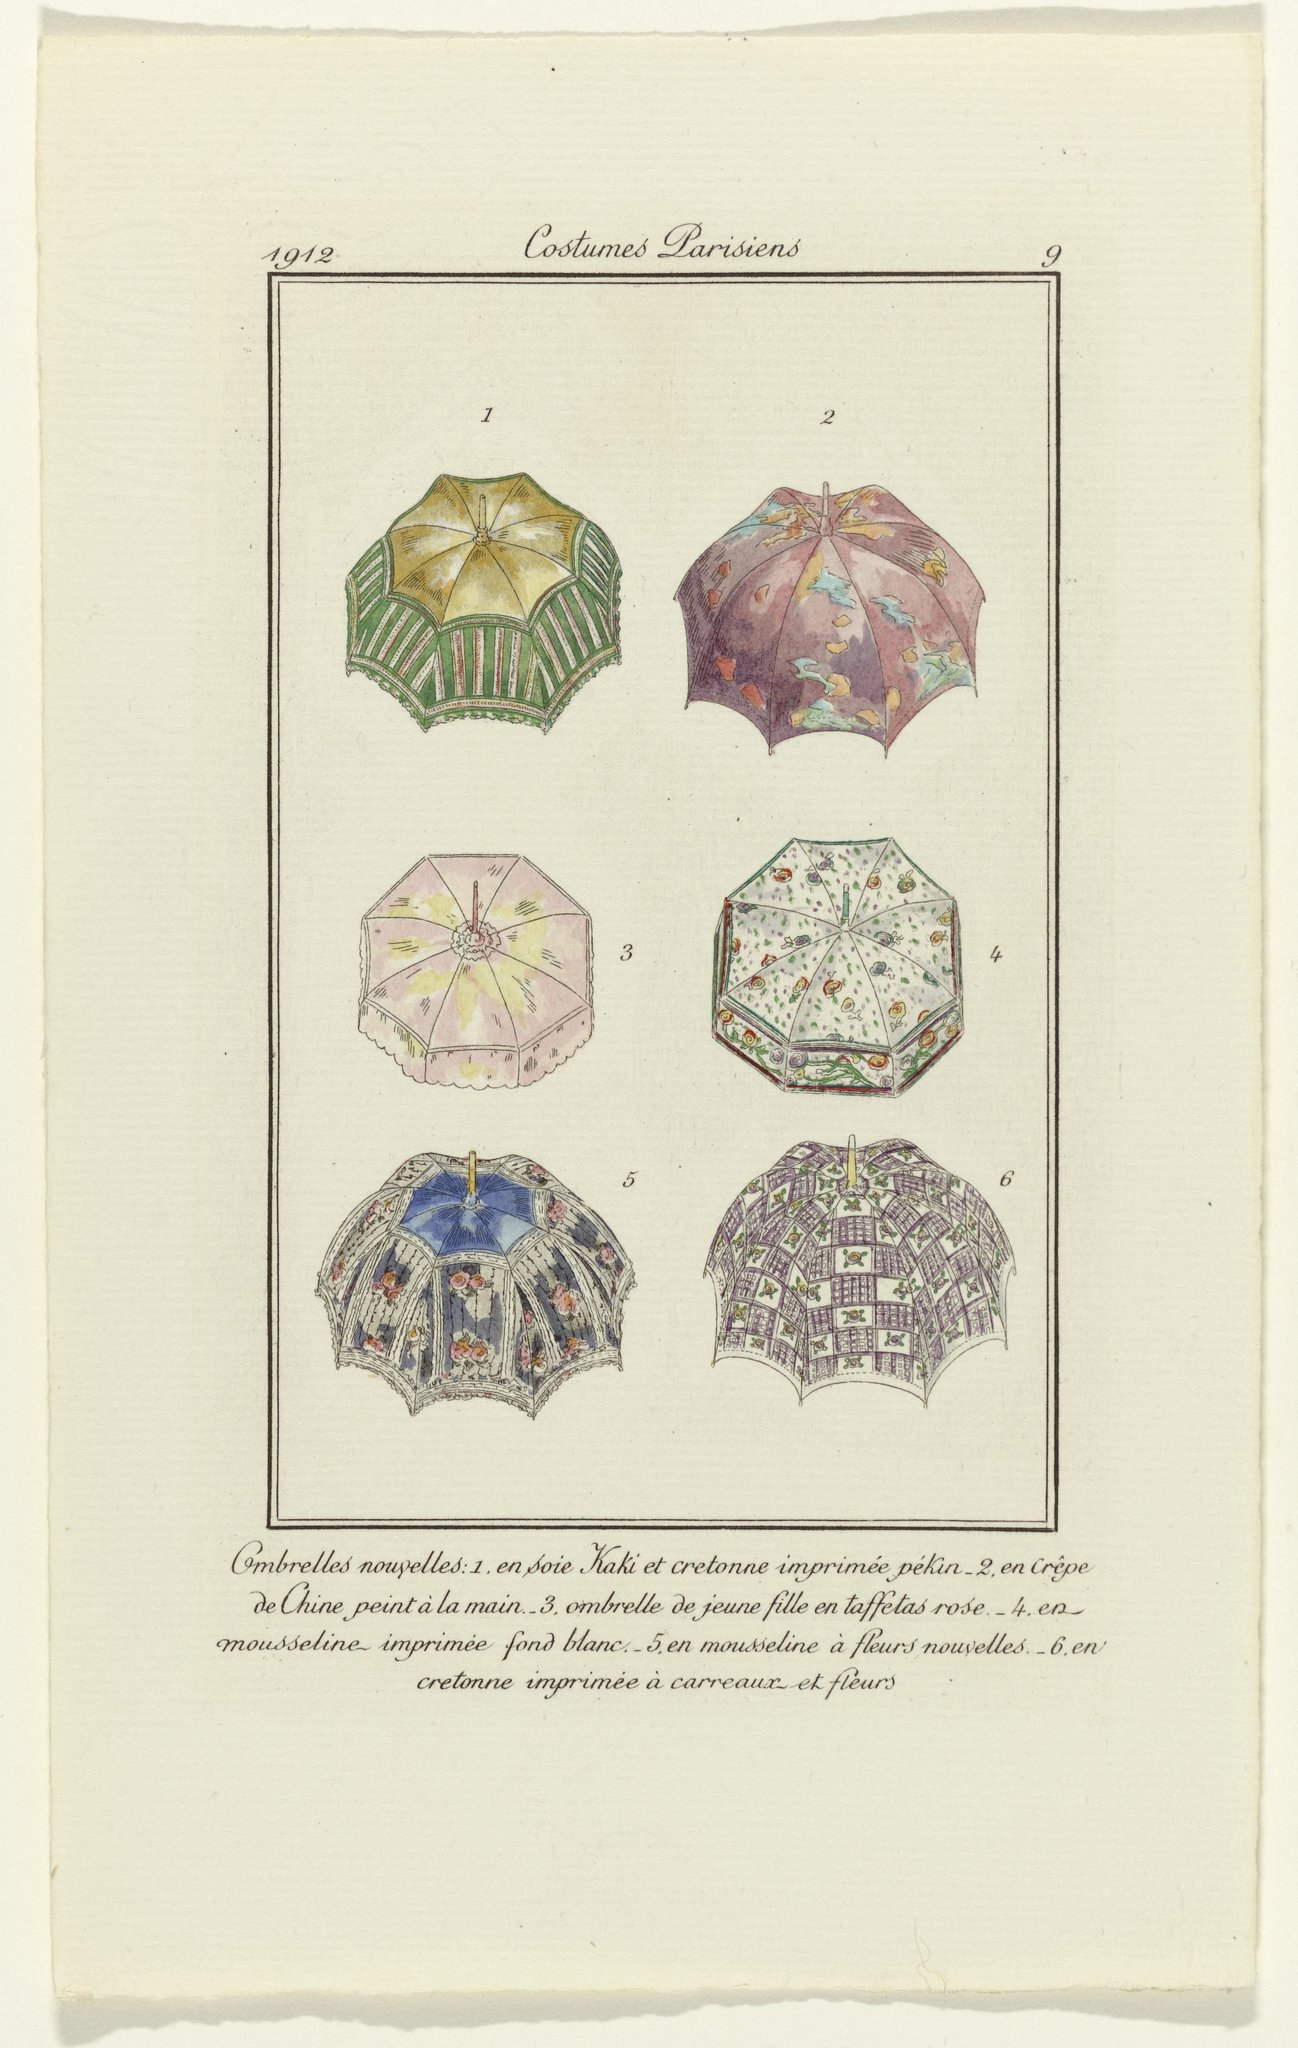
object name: fashion print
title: Accessories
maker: Anonymous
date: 1912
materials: paper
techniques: engraving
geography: paris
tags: fashion plates, umbrella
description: Fans, parasols, opera gloves, fashionable hats, small toques garnished with feathers, wristwatches, compact bracelets, and luxuriously crafted lighters: there was a dazzling variety of accessories in the 1920s. Small bags could be suspended from a belt, or a glove. Walking sticks and the shafts of umbrellas and parasols were often embellished with carving clearly inspired by African and Indian art. And Russian influence was evident when it came to combs made of mother-of-pearl and ivory.